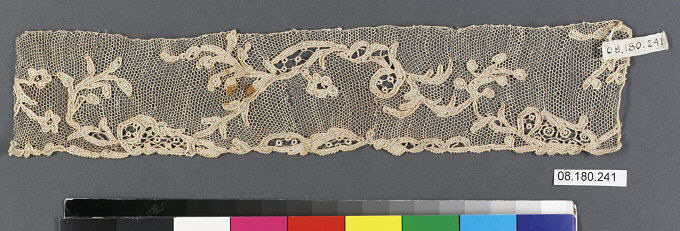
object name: border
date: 1701-1800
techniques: lace